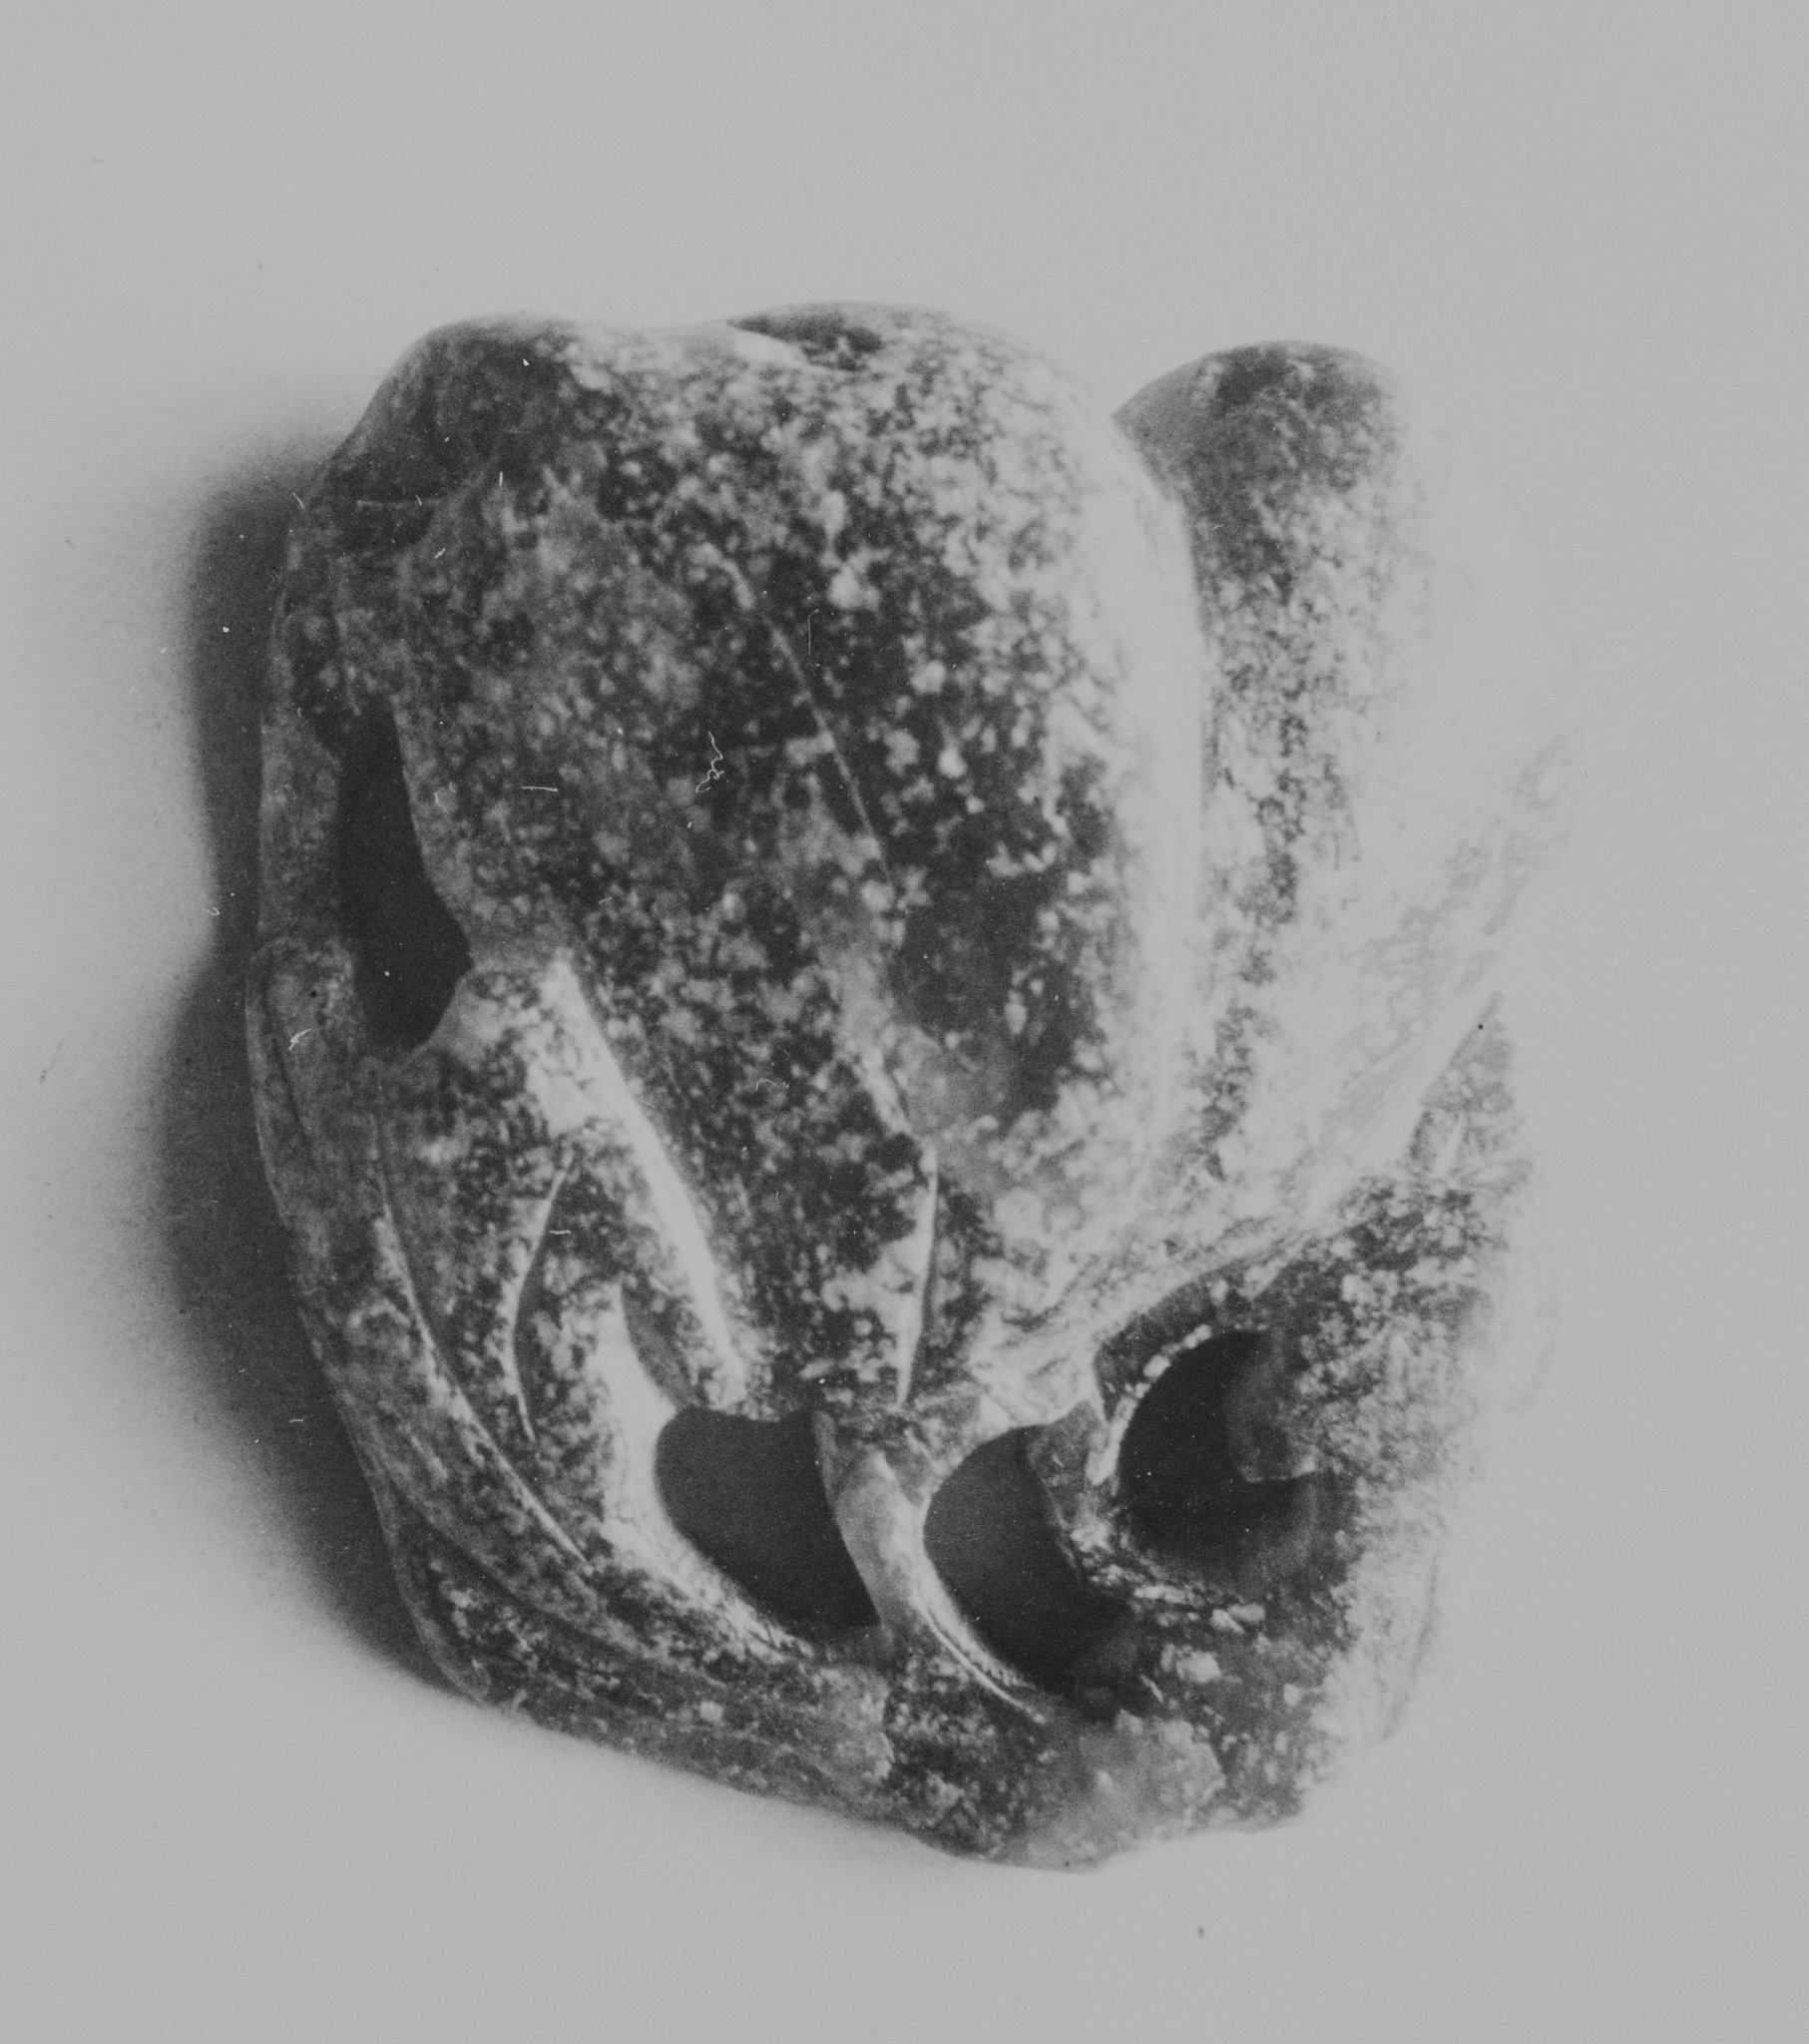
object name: ornament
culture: chinese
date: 618-907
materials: jade